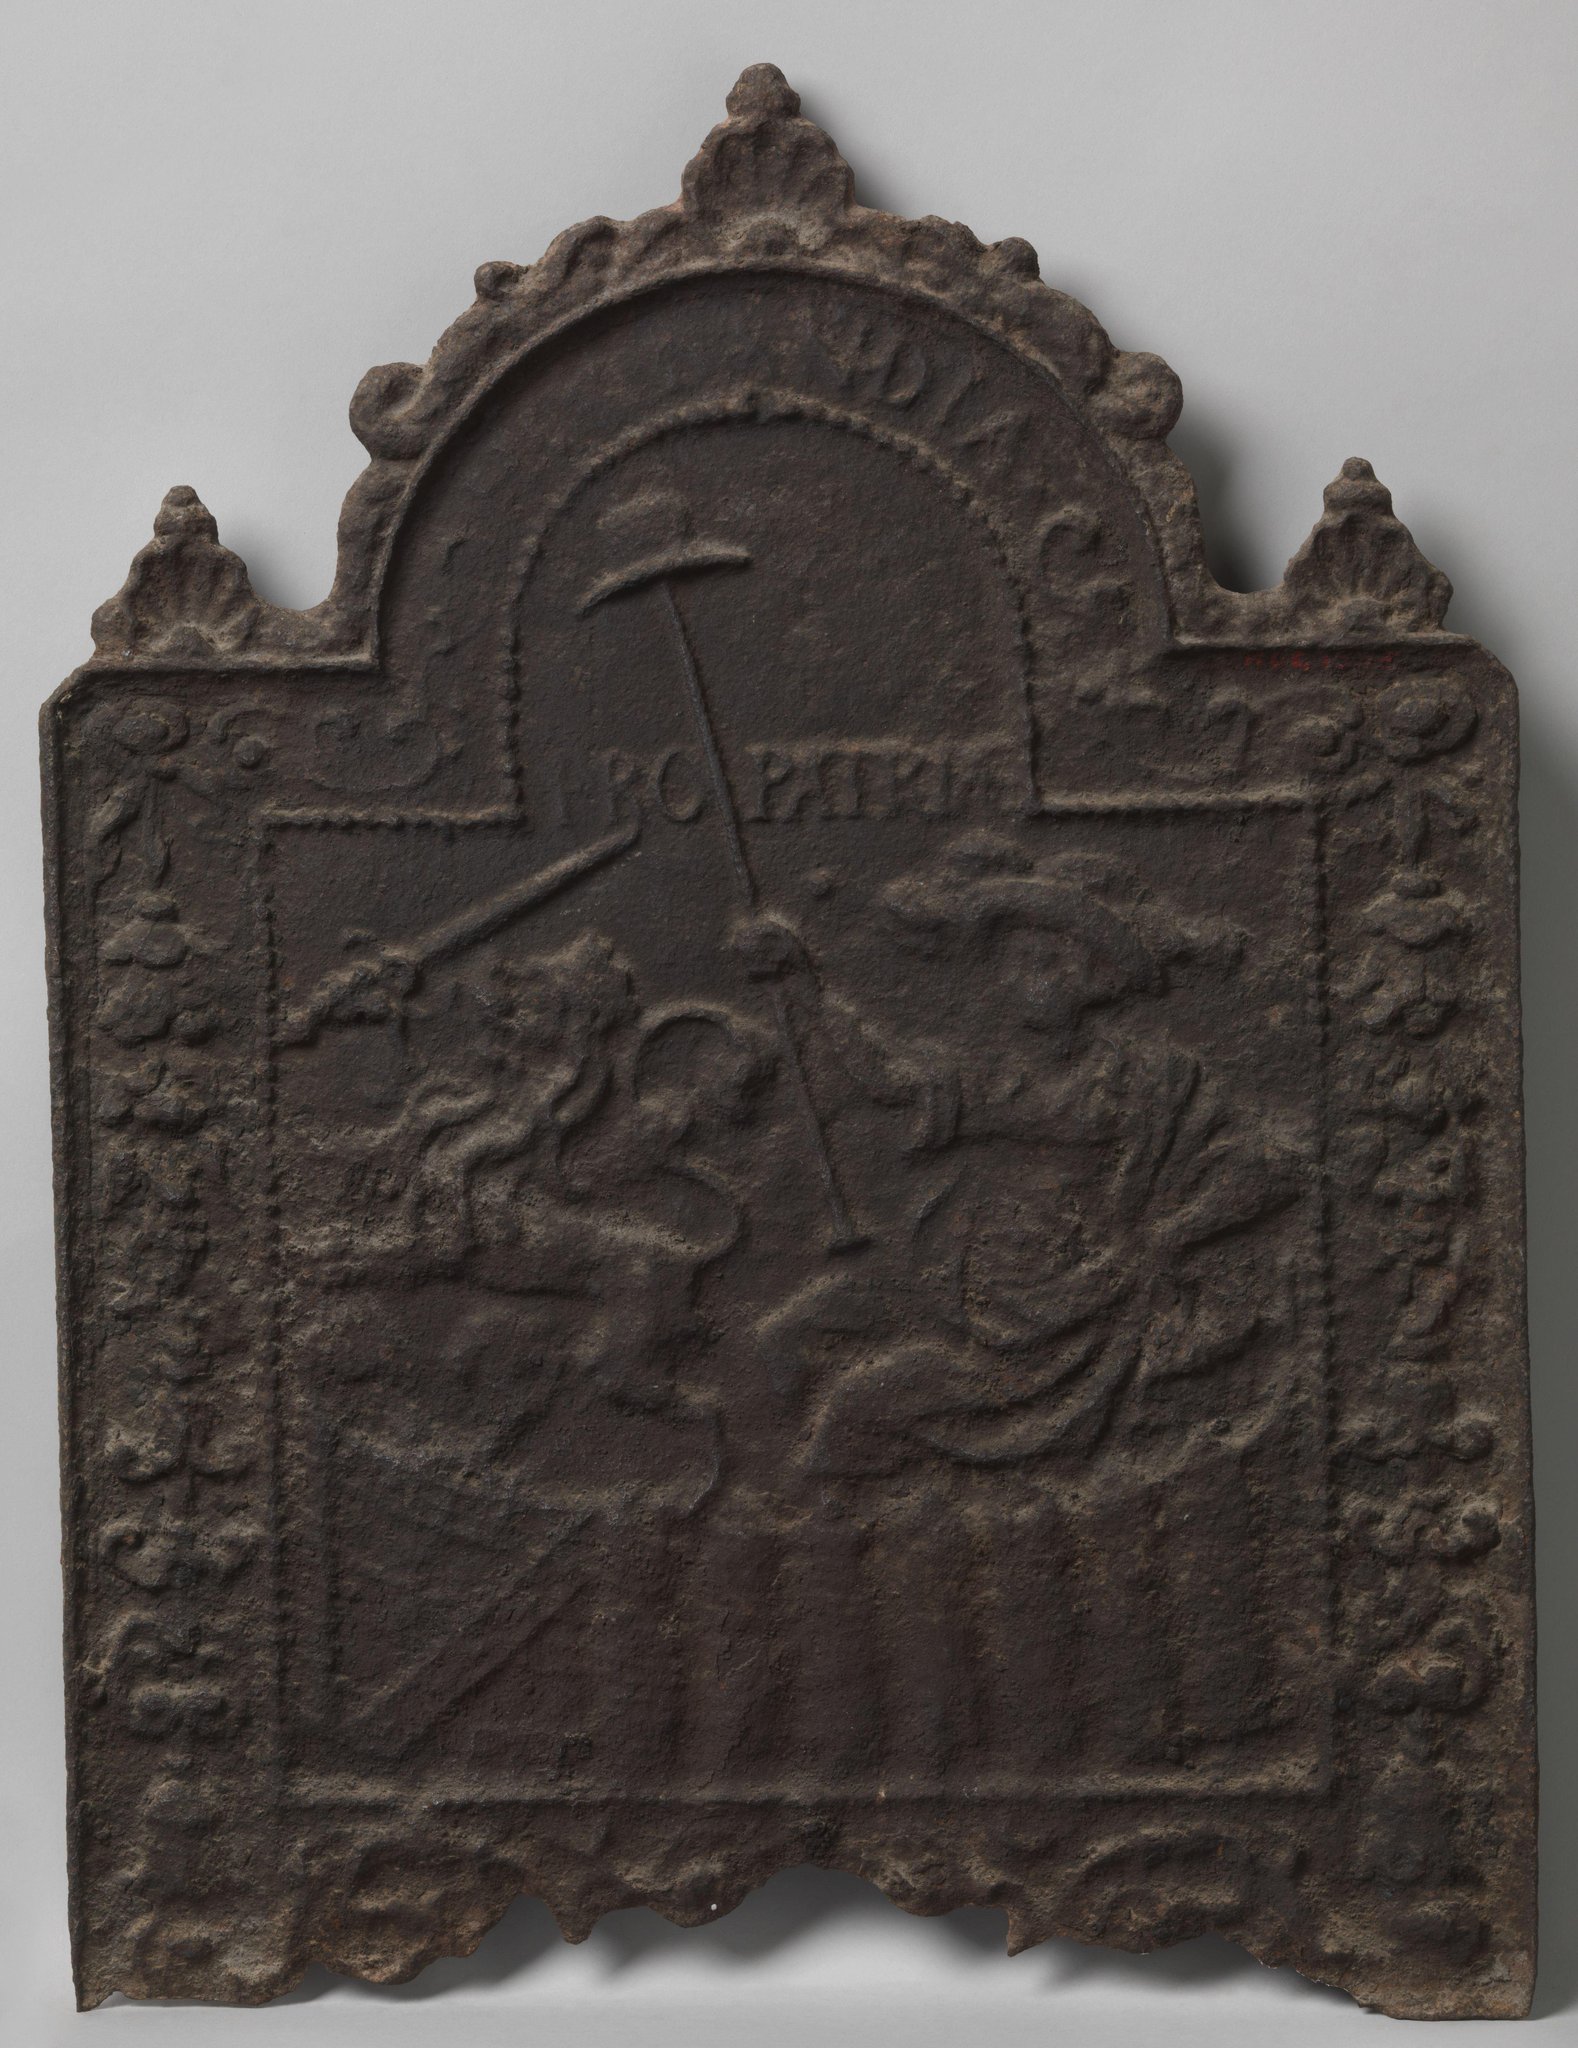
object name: fireback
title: Haardplaat met de Hollandse Maagd en Hollandse Leeuw in de Hollandse Tuin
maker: Anonymous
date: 1650-1700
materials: iron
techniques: casting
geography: germany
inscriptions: inscription: ‘PRO PATRIAE’, inscription: ‘HOLLANDIA’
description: Haardplaat van gietijzer, met halfronde bovenzijde. Centraal staan de Hollandse Leeuw en de Hollandse Maagd in de besloten Hollandse Tuin, die schuin vooraan een toegangspoort heeft. Direct boven hen het opschrift PRO PATRIAE. Het geheel is omlijst door een sierband, met een parelband en bloemen. Bovenaan in de rand staat HOLLANDIA. Het geheel wordt bovenaan afgesloten met drie schelpvormen met aan weerszijden een opklimmende dolfijn.